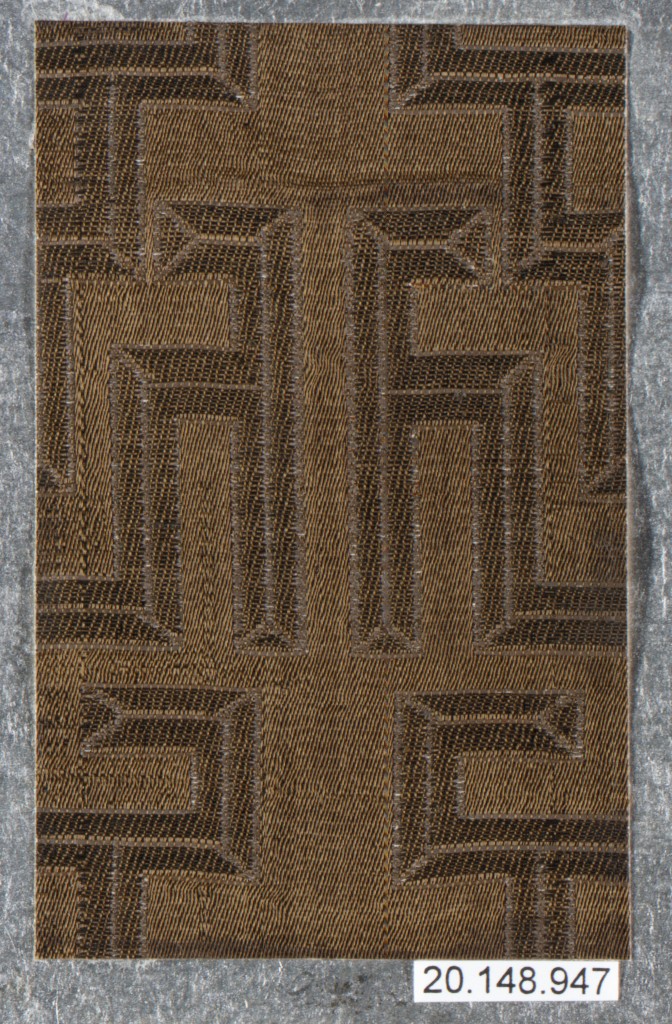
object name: piece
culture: japanese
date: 1701-1800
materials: silk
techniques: compound weave